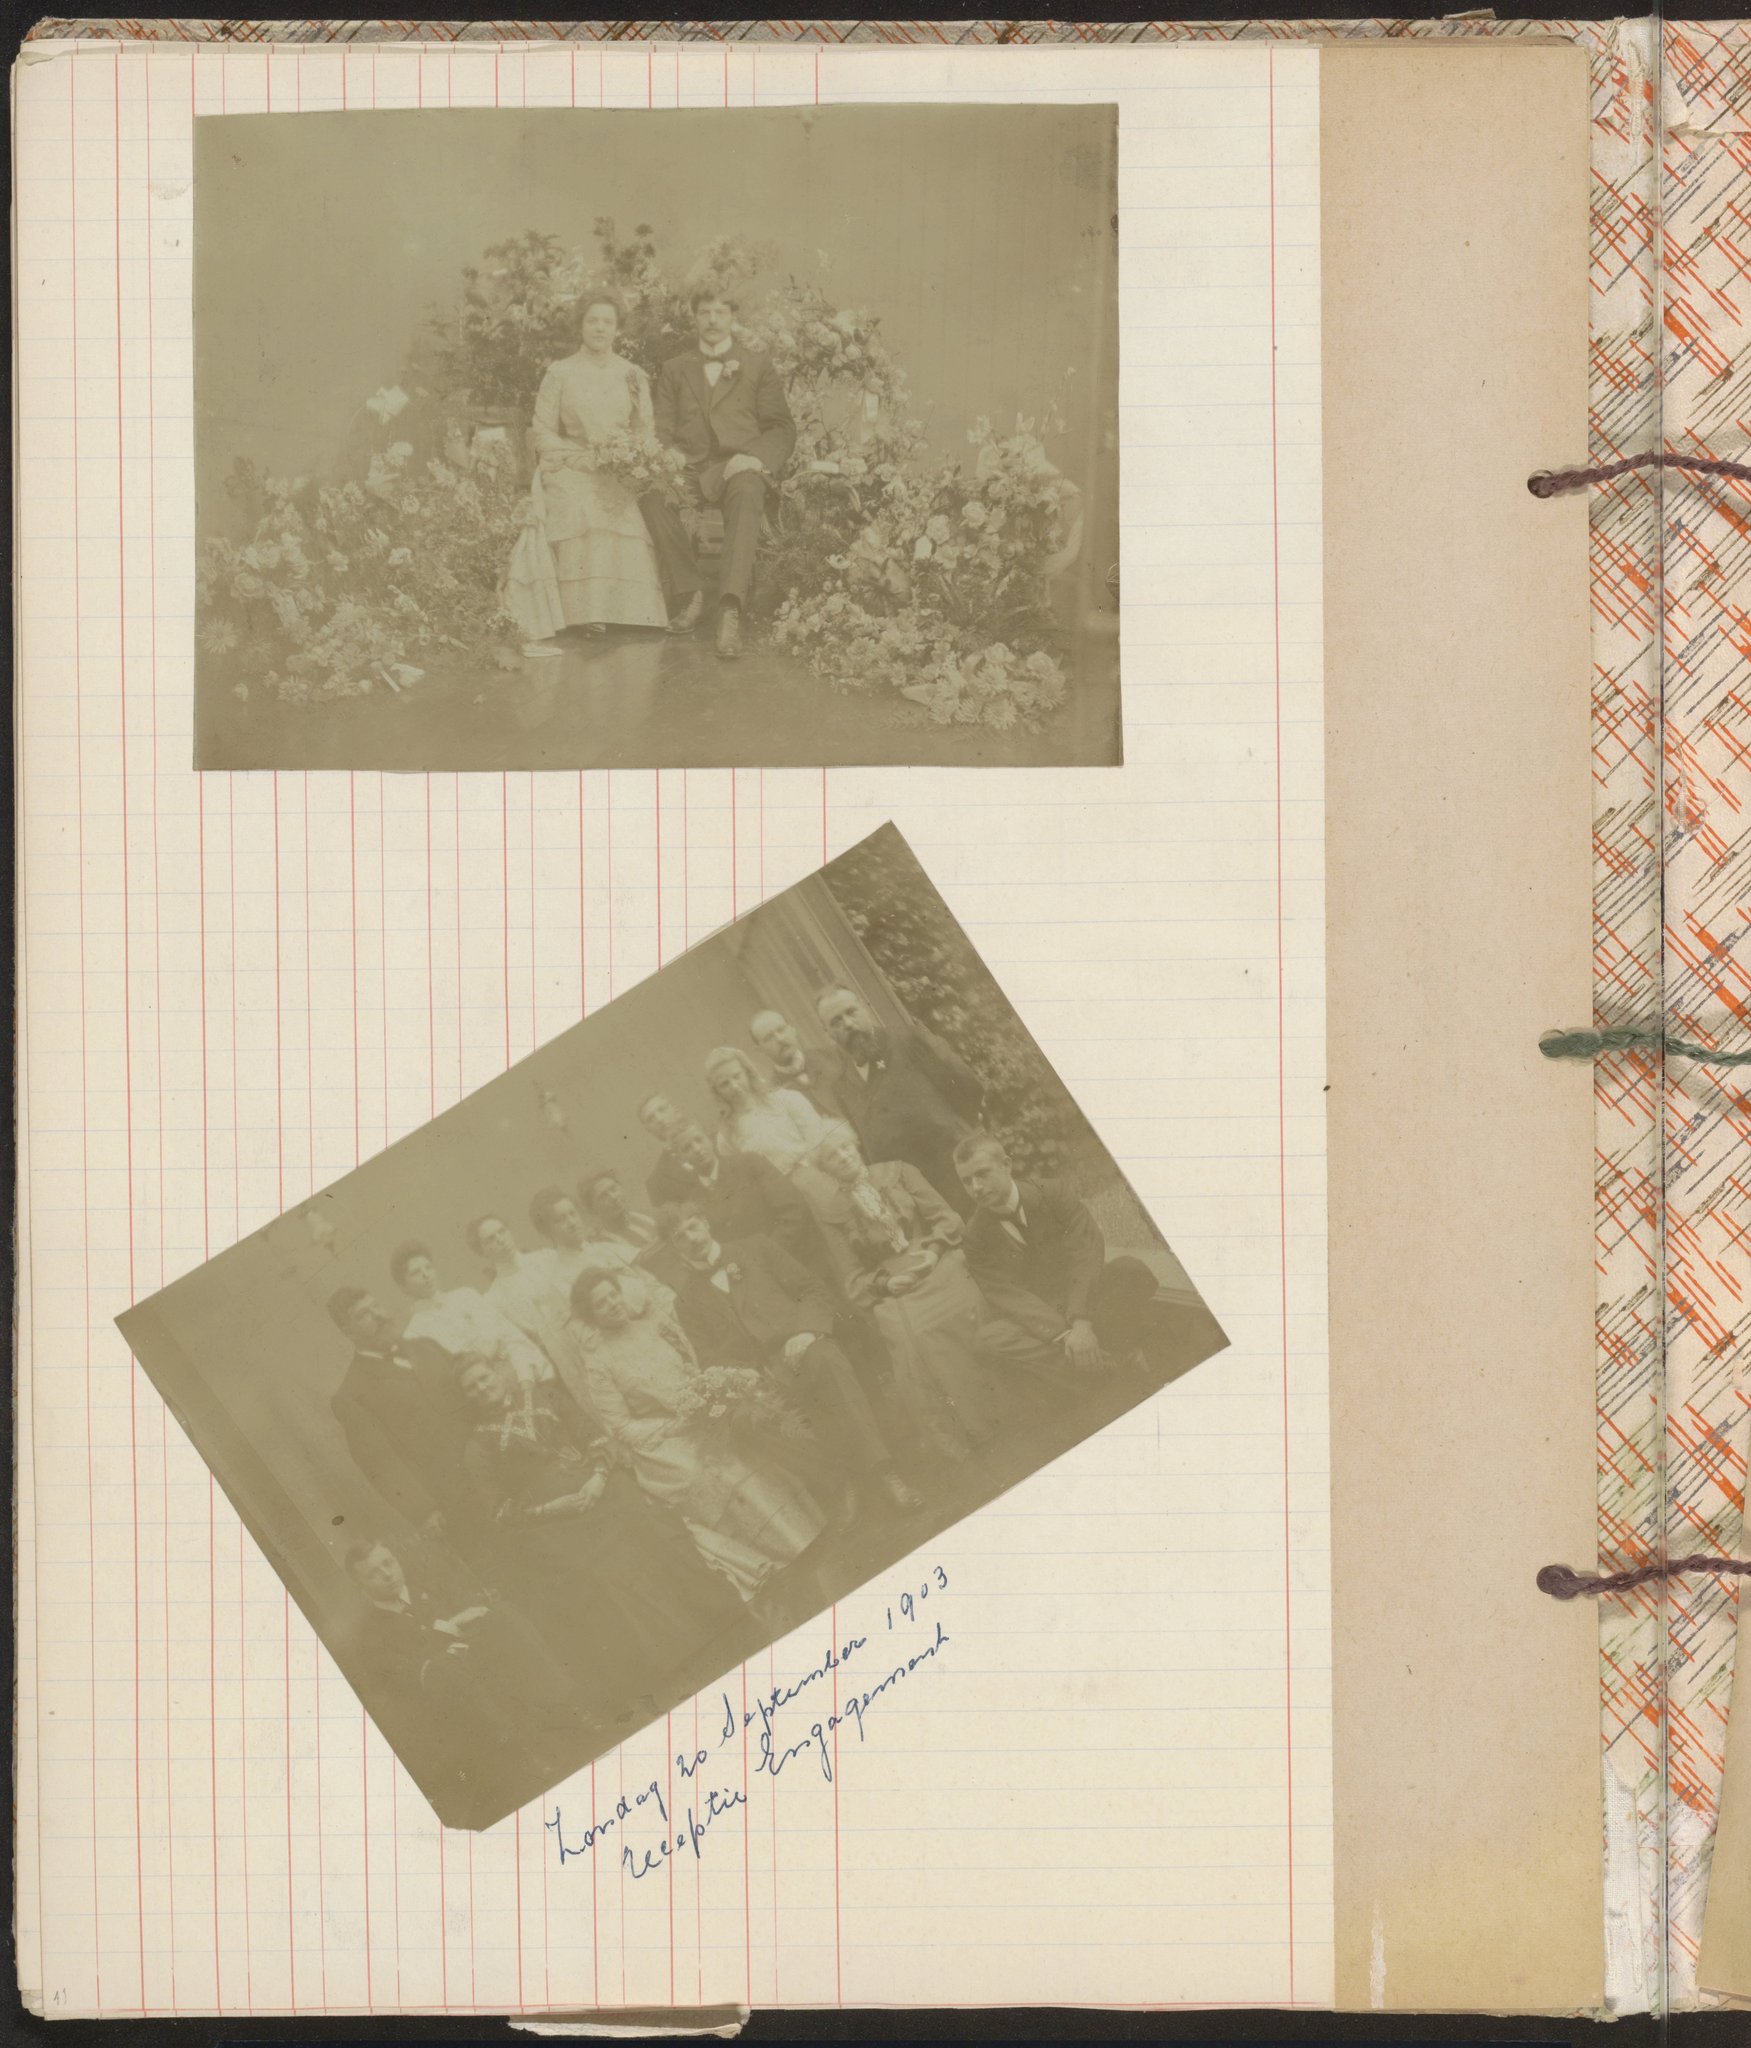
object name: album leaf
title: Verlovingsportretten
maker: Anonymous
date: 1903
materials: paper, photographic support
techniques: daylight paper print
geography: netherlands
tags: betrothal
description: Onderdeel van Fotoalbum van de familie Petri.